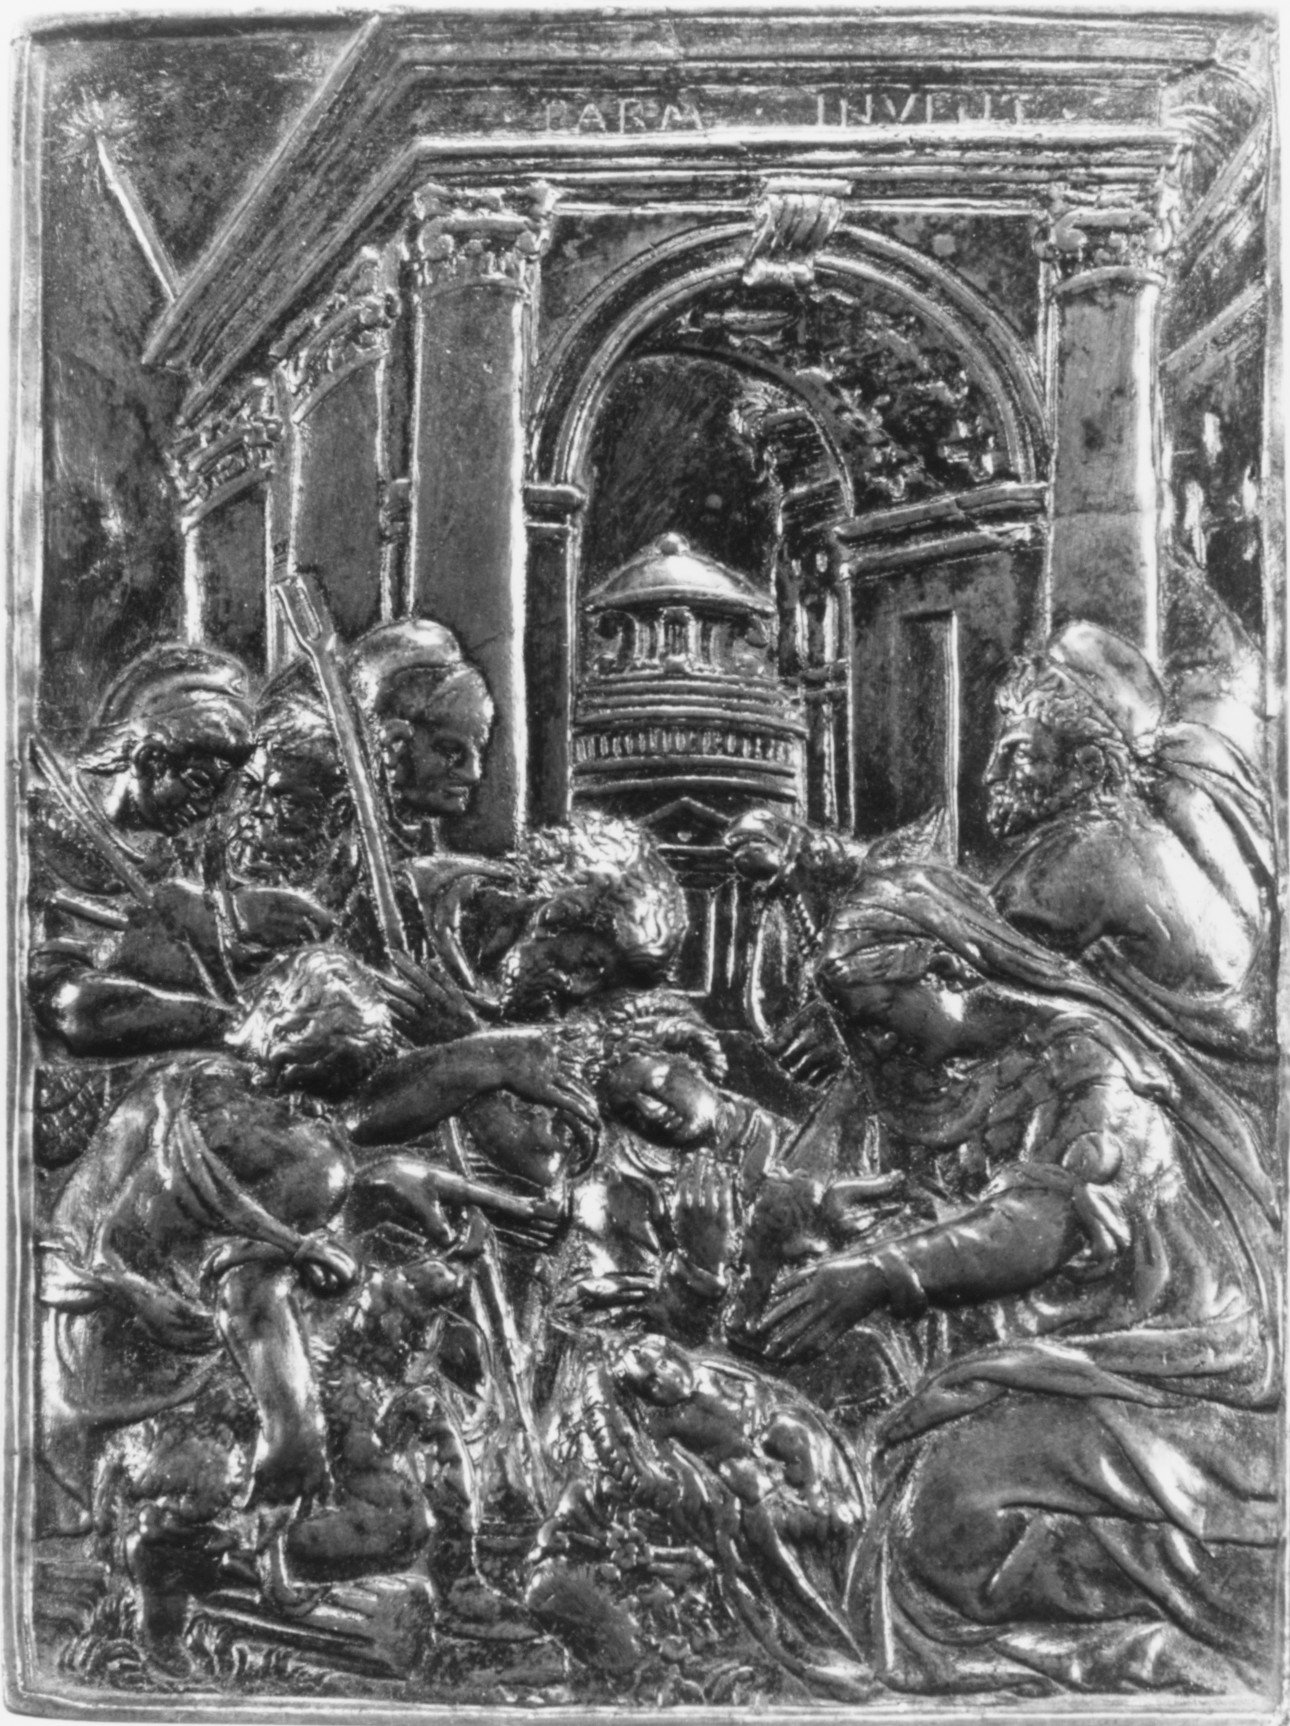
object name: plaquette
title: The Adoration of the Shepherds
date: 1501-1600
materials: bronze, patina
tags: men,women,madonna and child,adoration of the shepherds